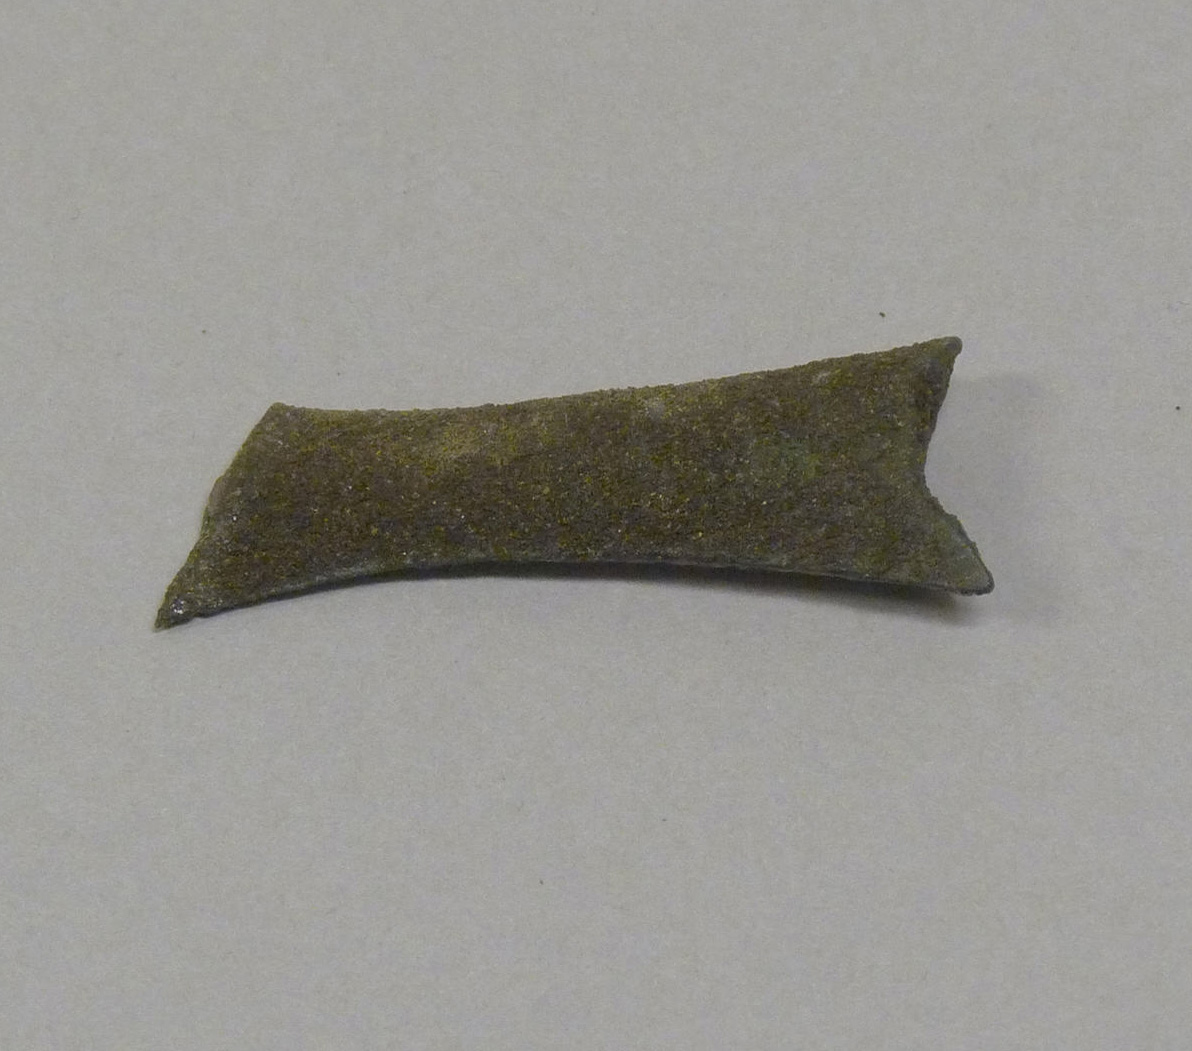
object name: ax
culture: indonesian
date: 500 BCE-300 CE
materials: bronze